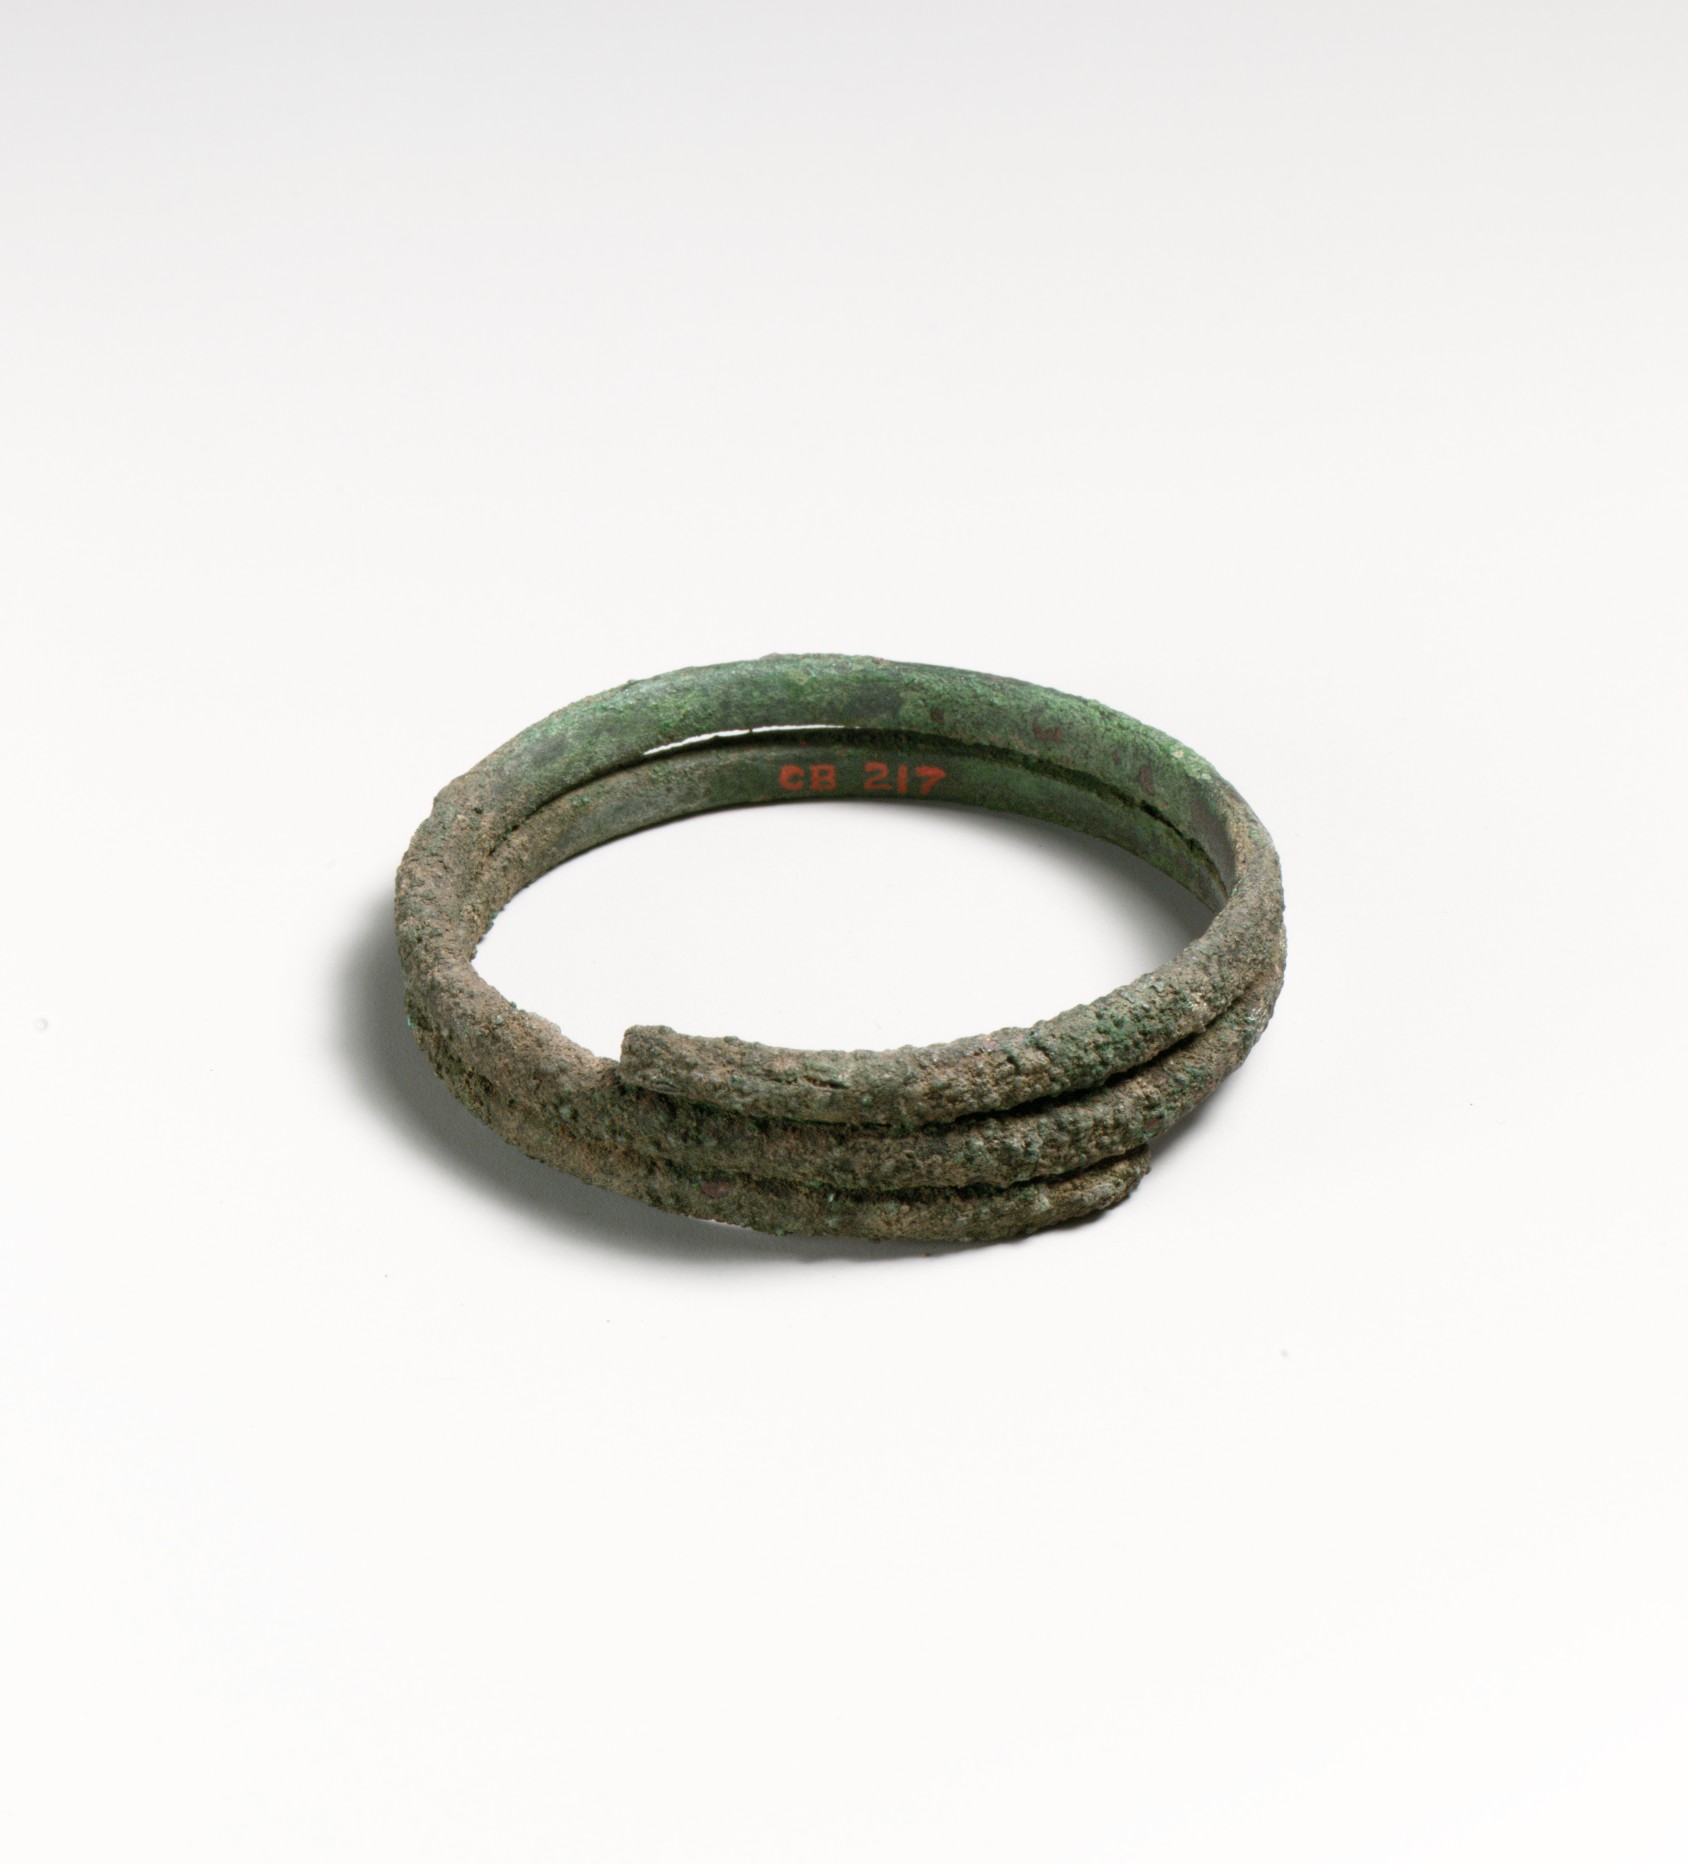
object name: bracelet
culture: cypriot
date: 3900 BCE-100 CE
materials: bronze